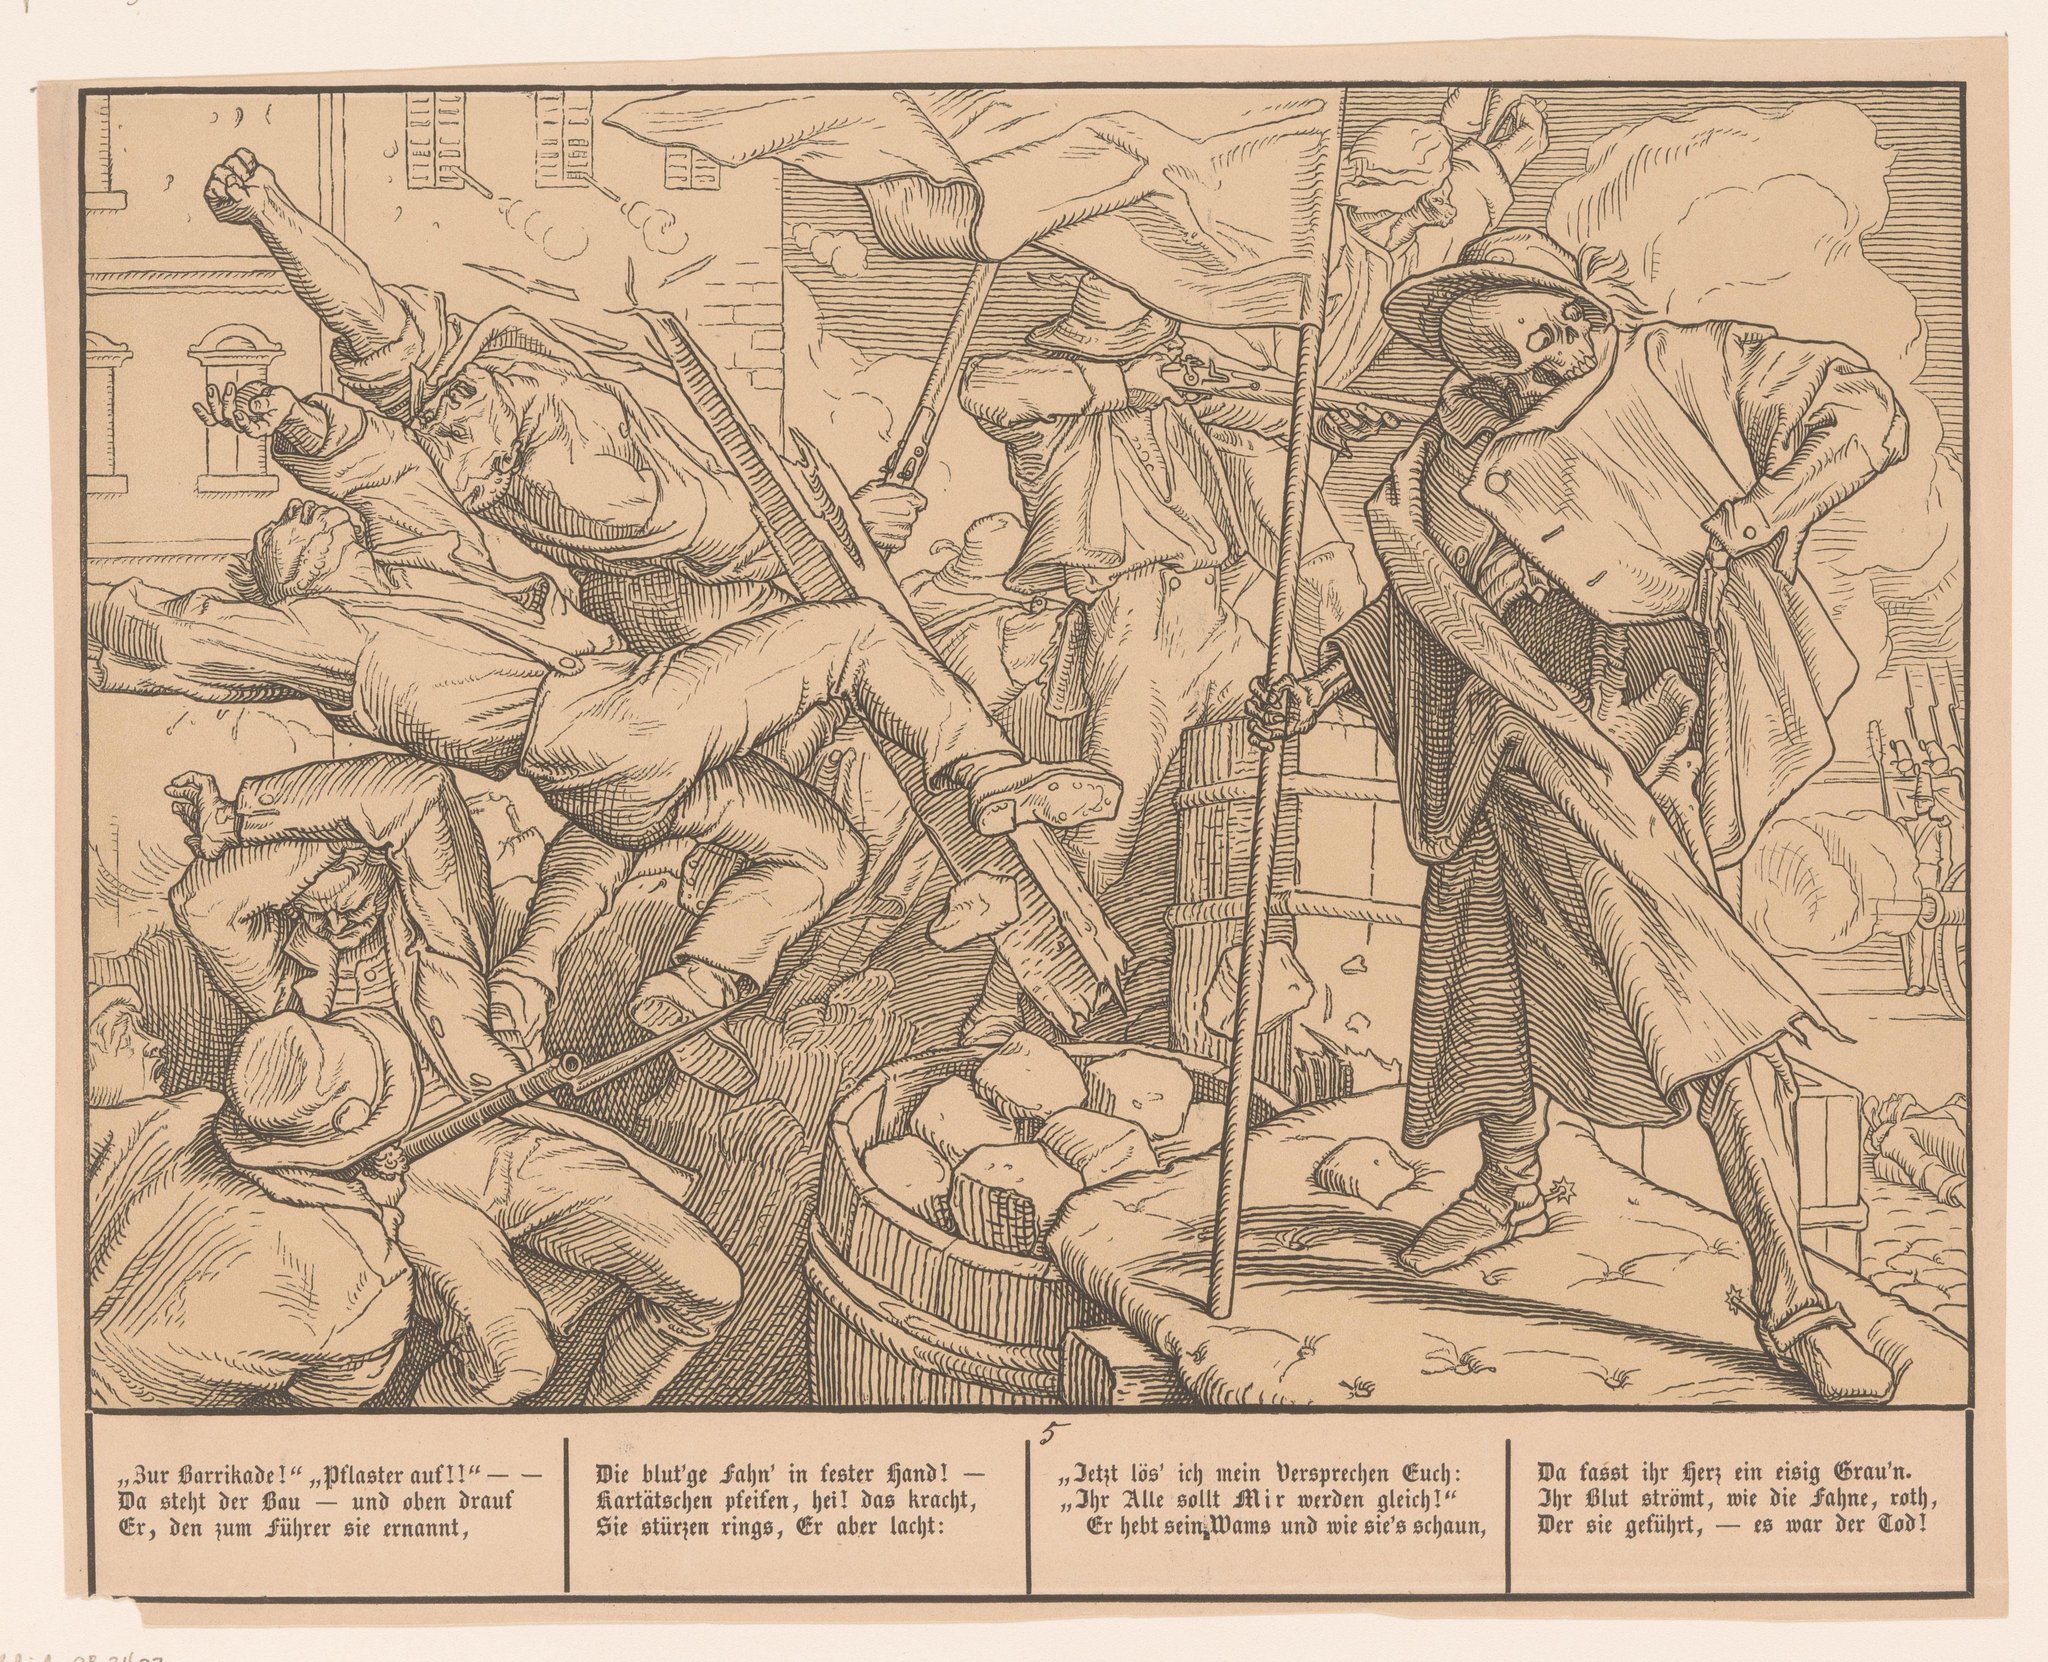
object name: print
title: Der Tod auf der Barrikade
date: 1848-1849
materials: paper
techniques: woodcut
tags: dance of death; death together with one or more human beings, revolution, revolt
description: Allegorie op de revolutie in de Duitse landen van 1848: "Ein Totentanz aus dem Jahre 1848", Volksuitgave van Augustus.